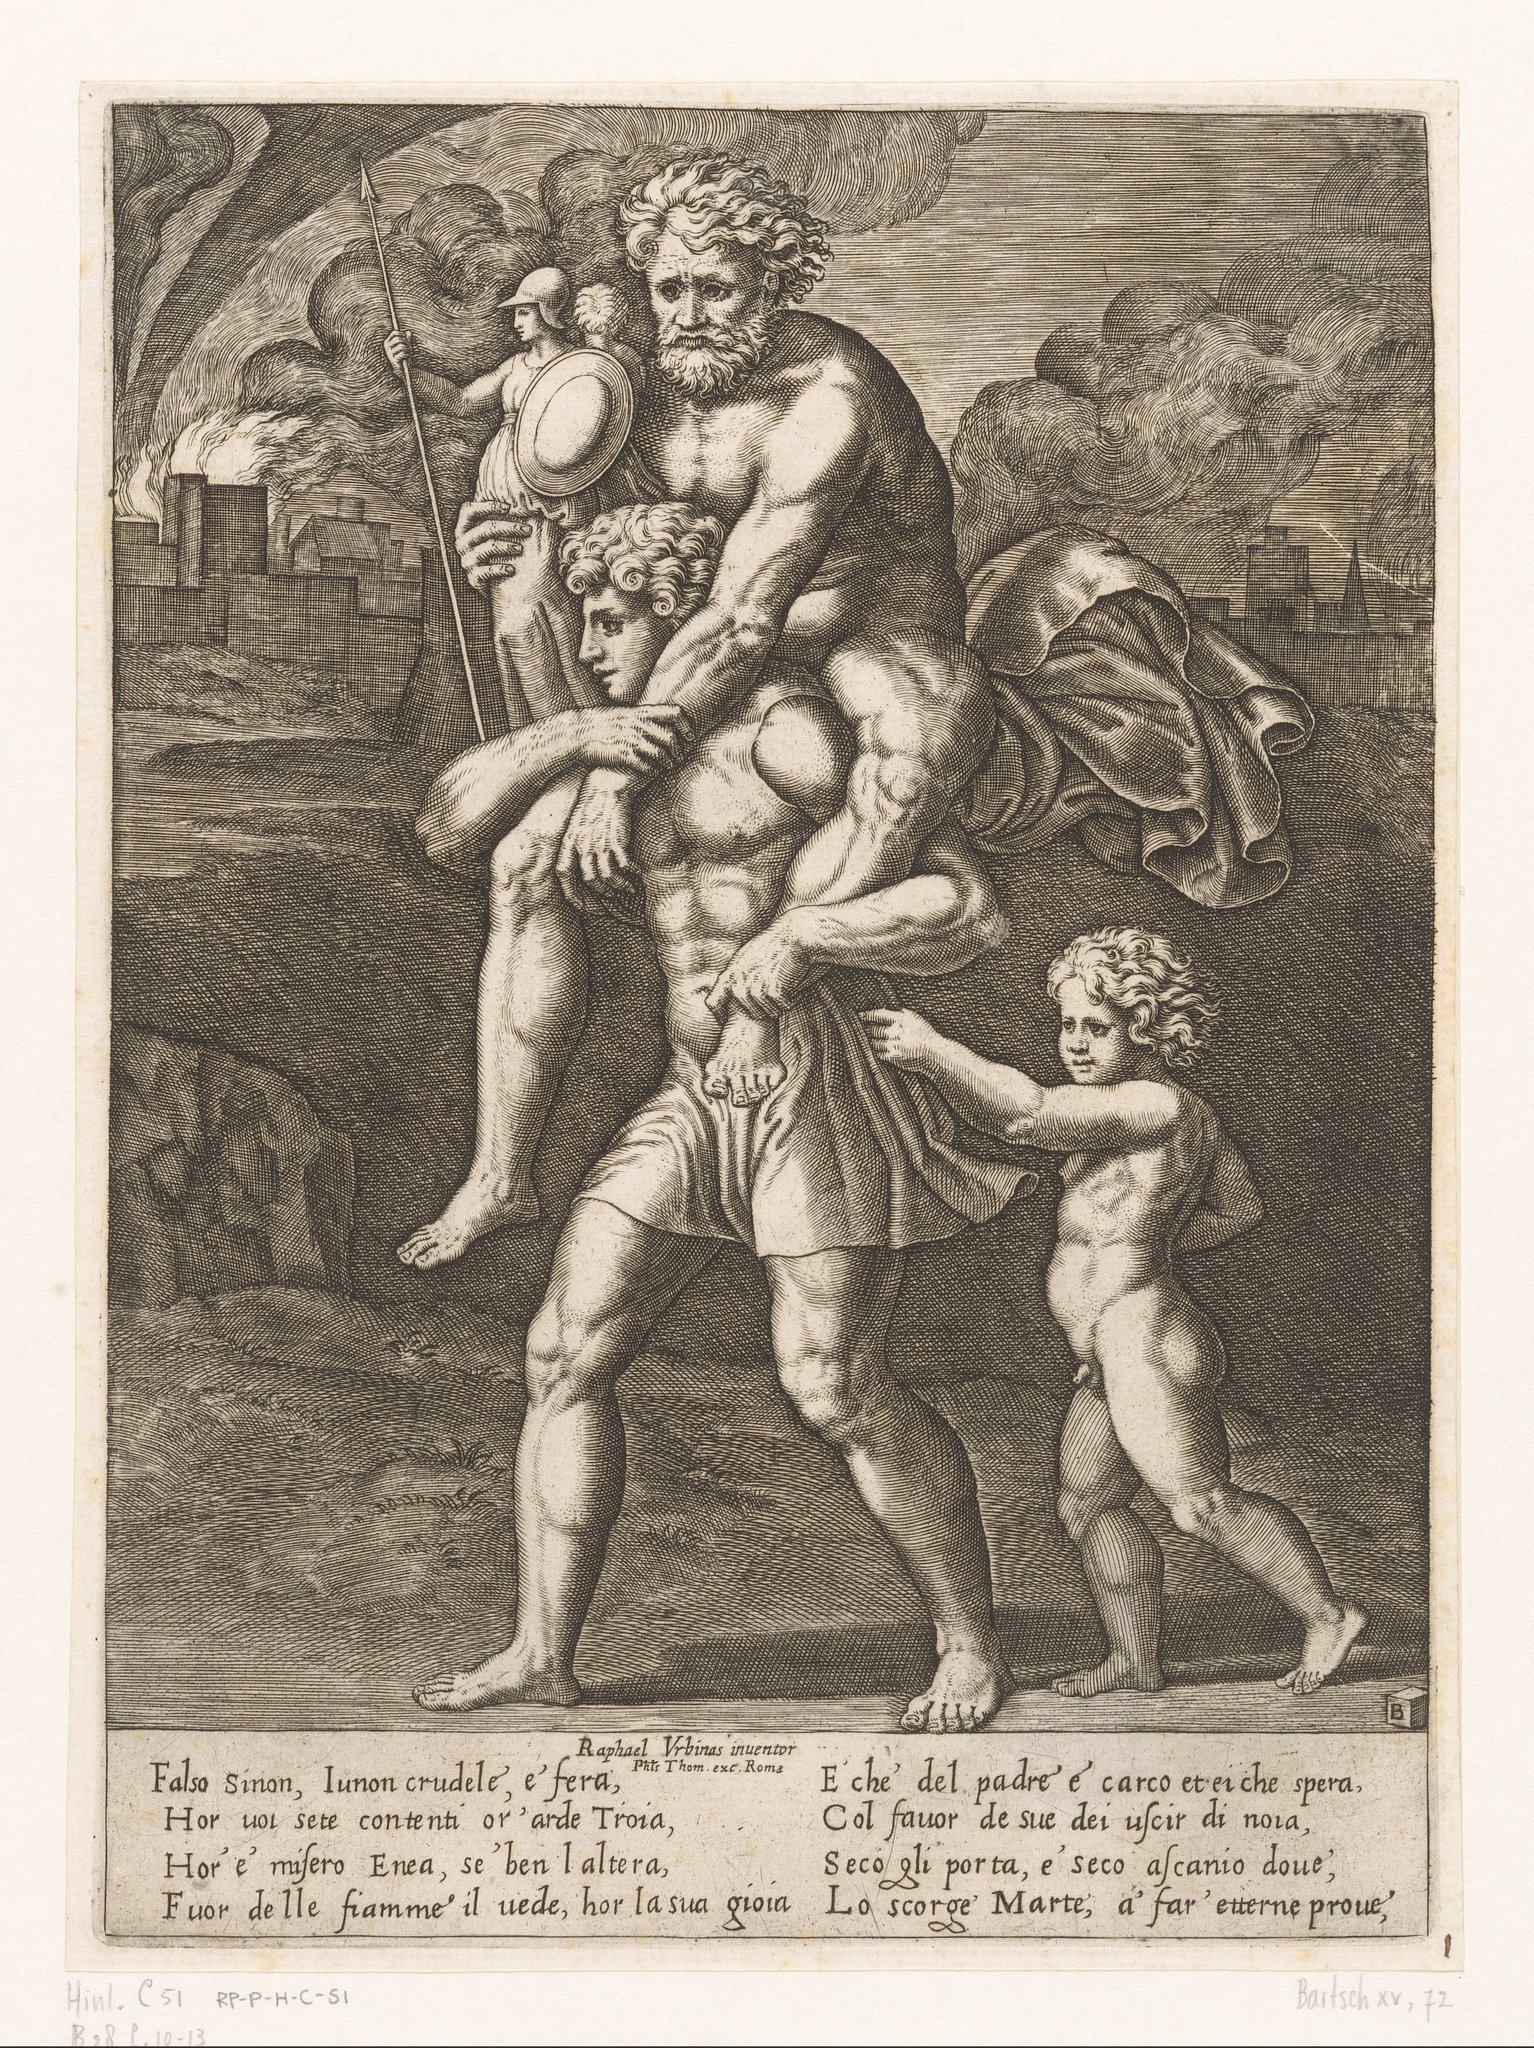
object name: print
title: Aeneas en zijn familie vluchten uit Troje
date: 1530-1560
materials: paper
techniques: engraving, intaglio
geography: rome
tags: 'pius aeneas': aeneas, leading ascanius, escapes from burning troy, carrying his father anchises with the penates; his wife creusa, who sets out with them, is lost on the way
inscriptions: collector's mark: Lugt 10, collector's mark: ‘Hinloopen’, number: ‘1’, collector's mark: Lugt 11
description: Aeneas loopt met zijn vader Anchises op de rug. In zijn rechterhand draagt Anchises de huisgoden (Penates). Achter Aeneas loopt zijn zoon Ascanius. Op de achtergrond het brandende Troje. Italiaanse tekst in twee kolommen in ondermarge.